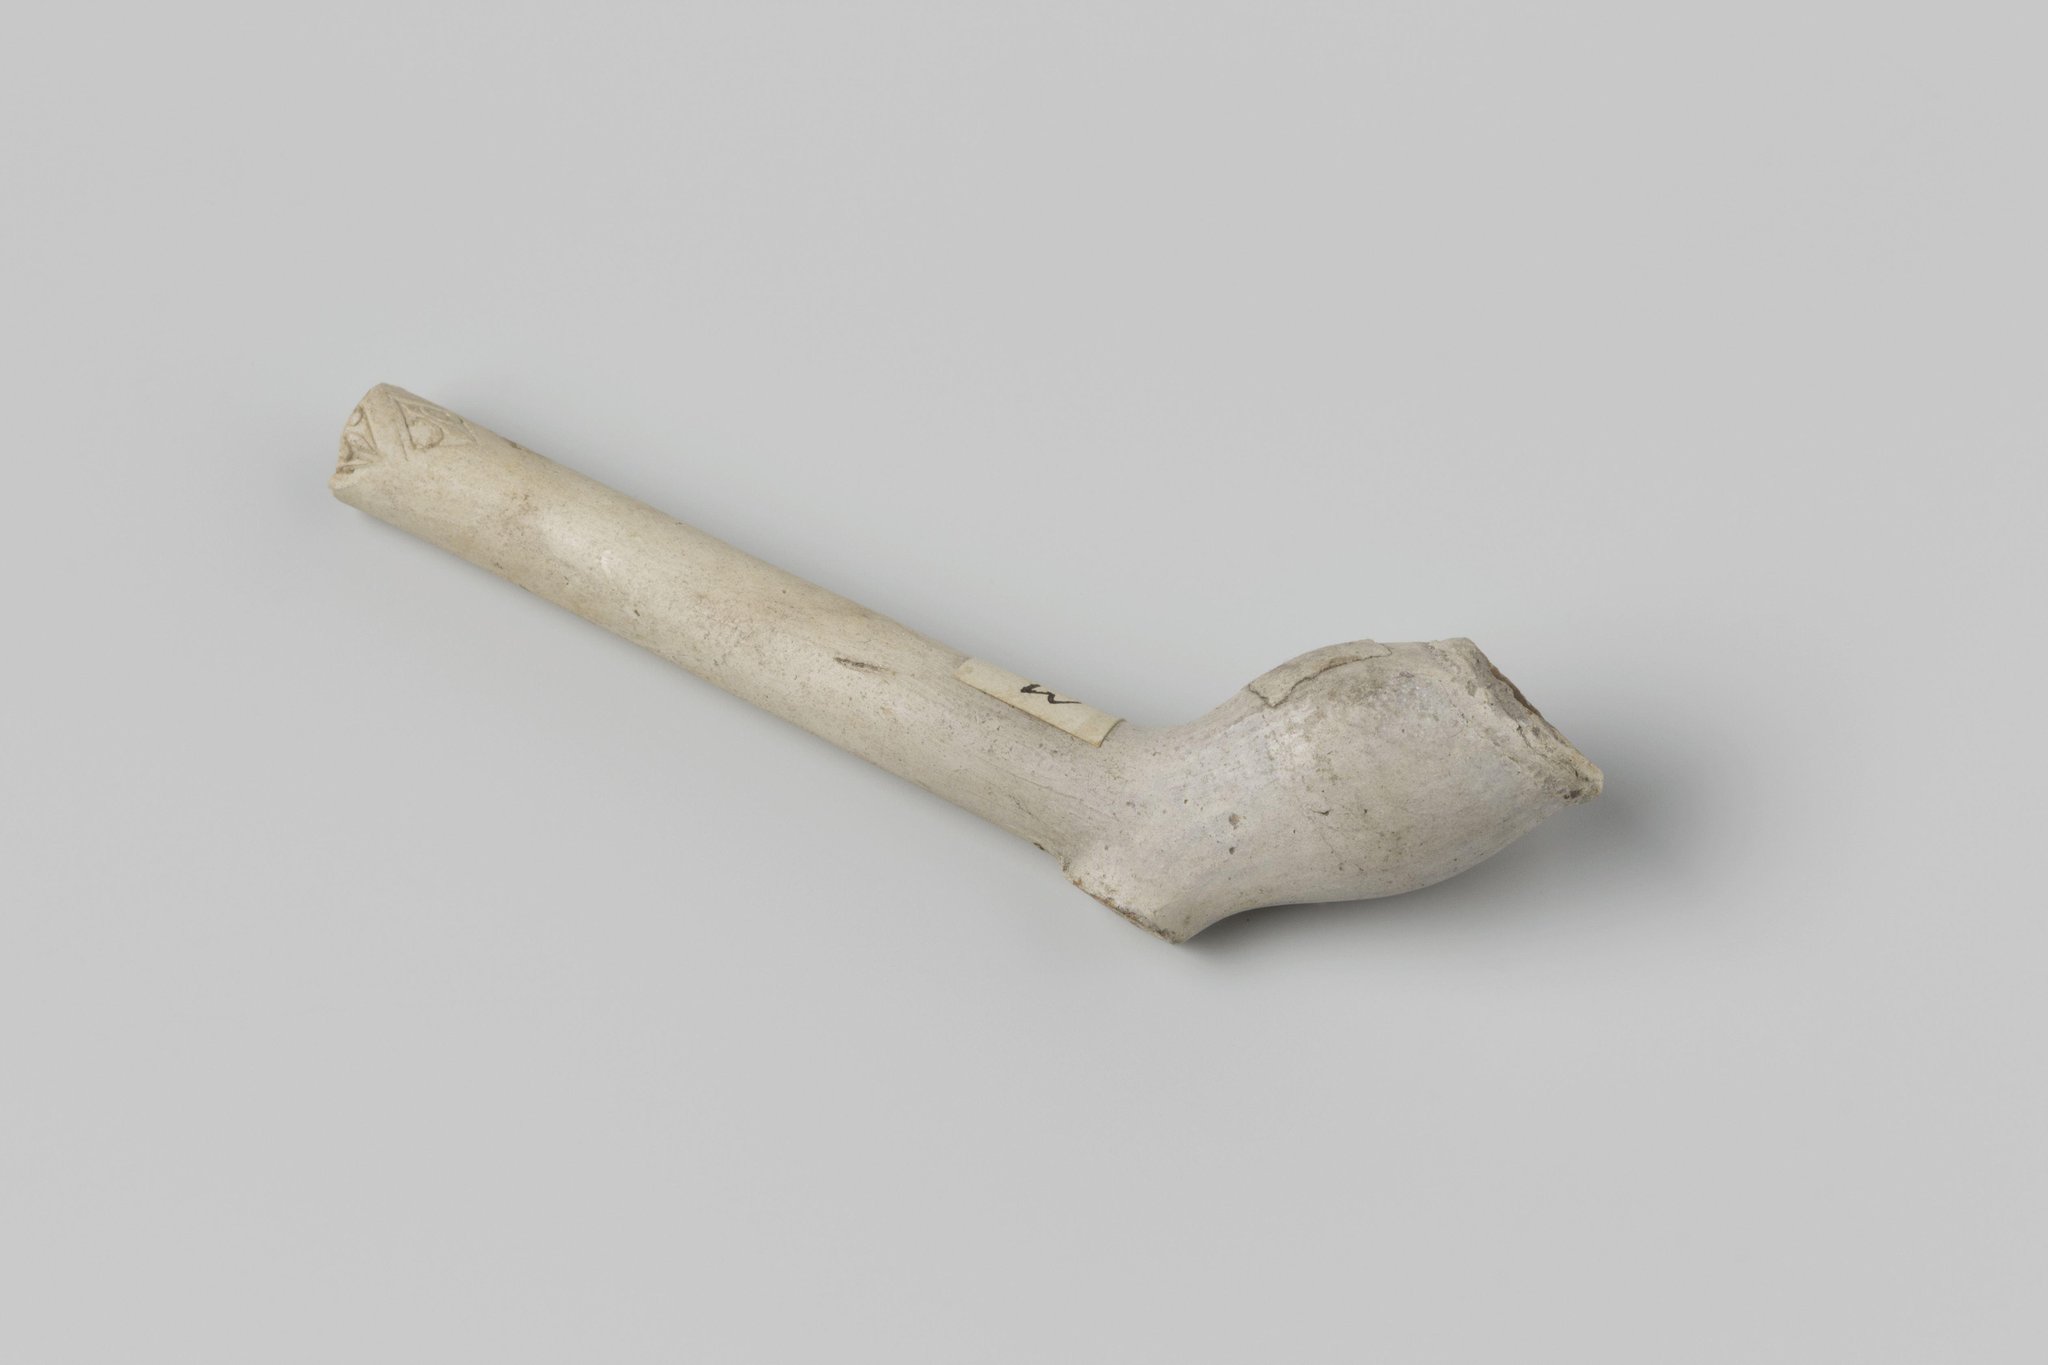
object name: pipe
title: Tabakspijp.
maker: Anonymous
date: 1400-1950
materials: earthenware, clay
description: Tabakspijp, op de steel: losanges, waarin een lelie stempel lelie, daaronder ?